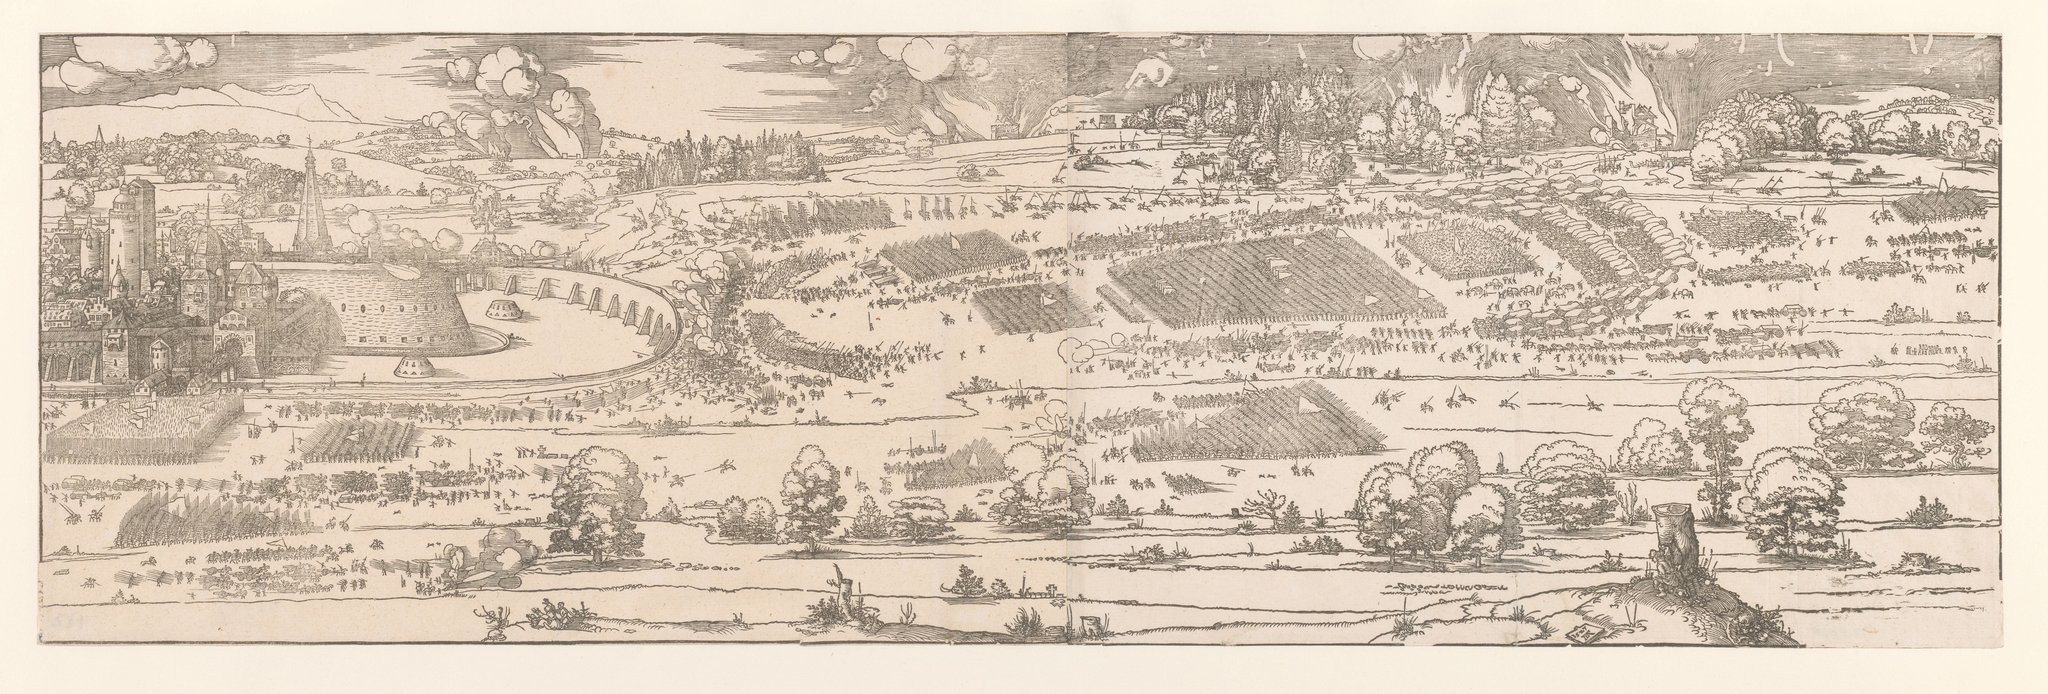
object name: print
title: Beleg van een vesting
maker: albrecht dürer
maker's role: draughtsman, painter, print maker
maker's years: 1471-1528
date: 1527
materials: paper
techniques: woodcut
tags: siege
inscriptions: date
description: Prent gebruikt in: Dürer, Albrecht. Etliche Vnderricht zu Befestigung der Stett Schloss vnd Flecken. Nürnberg: s.n., 1527.